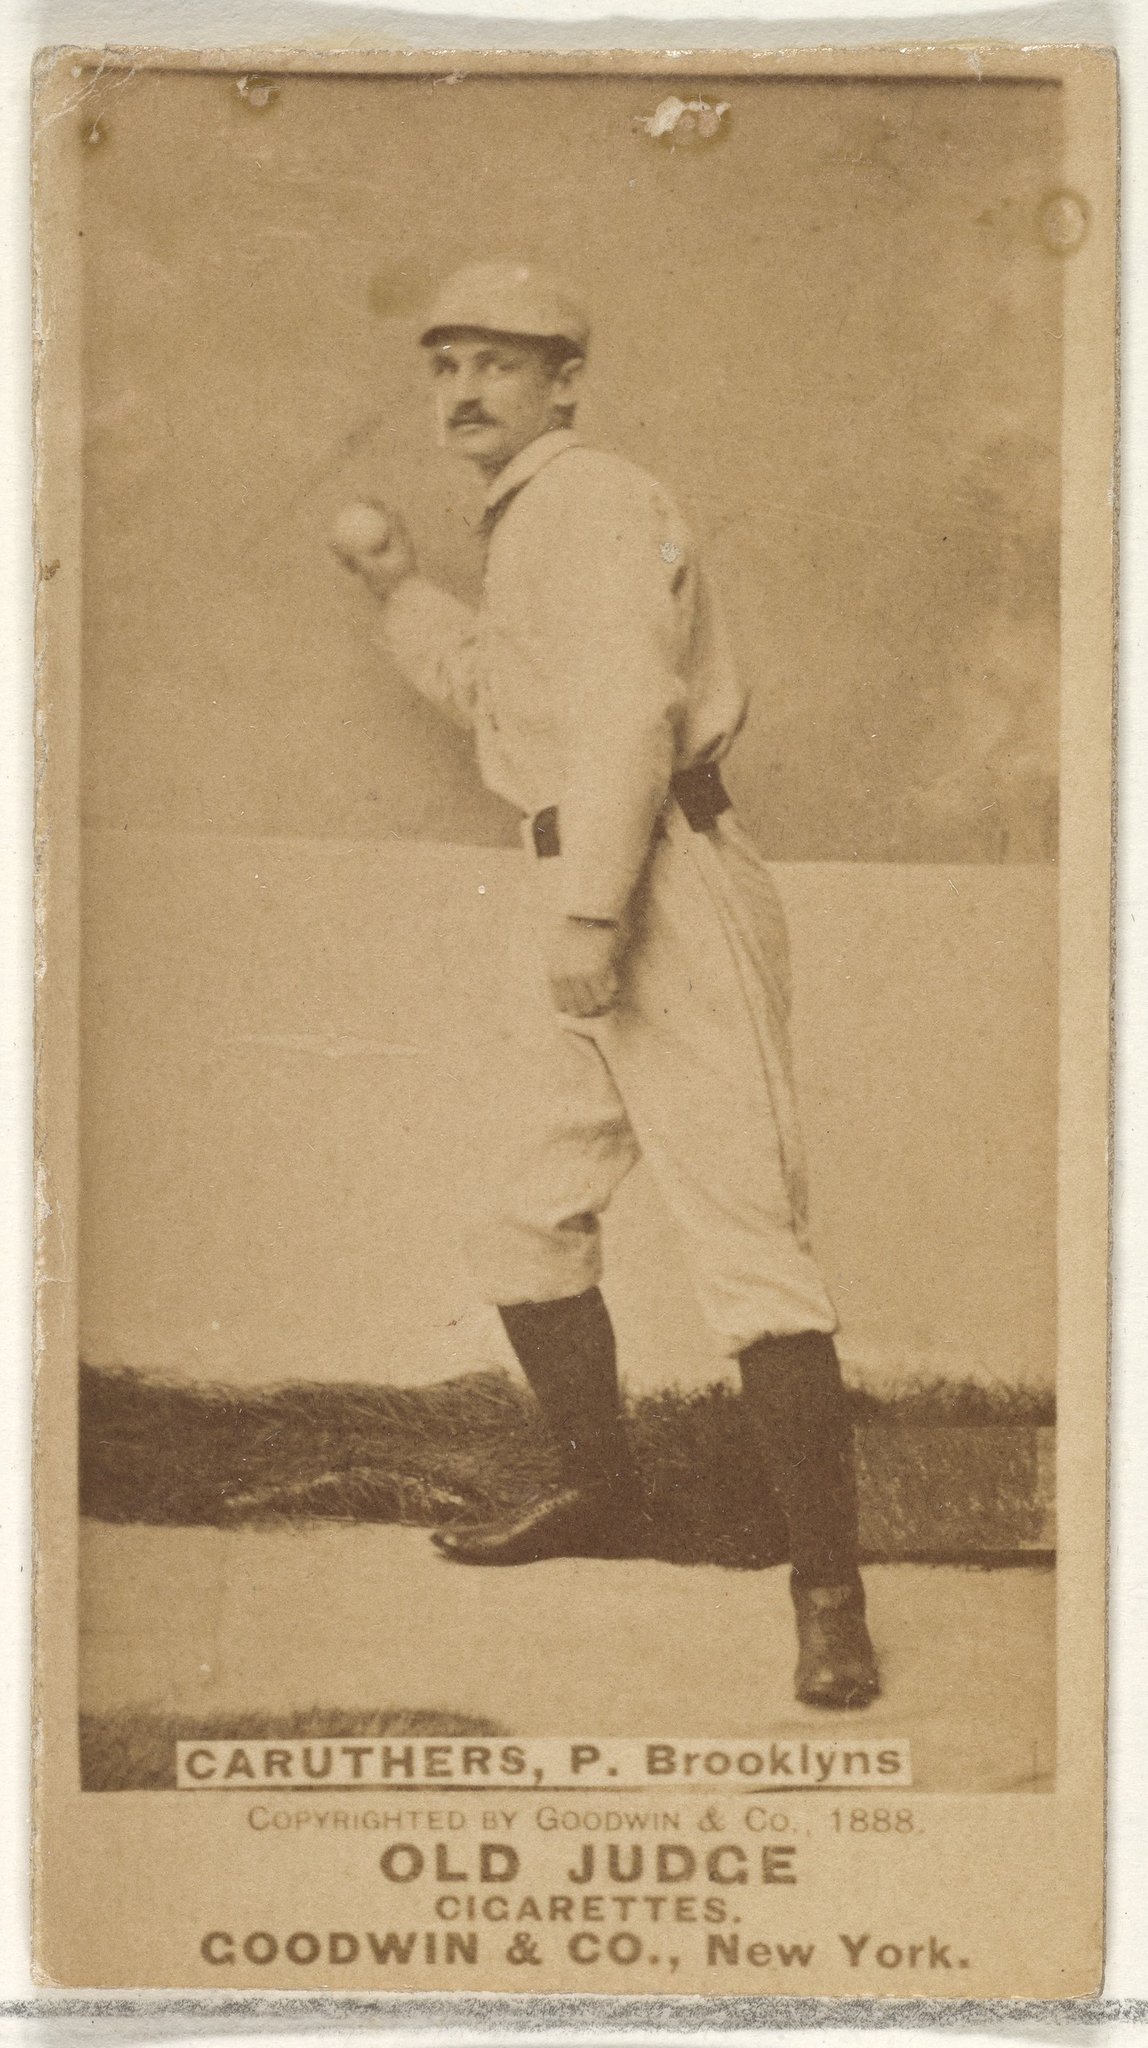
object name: baseball card, photograph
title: Caruthers, Pitcher, Brooklyn, from the Old Judge series (N172) for Old Judge Cigarettes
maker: goodwin & company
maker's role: publisher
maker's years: 1850-1950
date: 1888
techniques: albumen silver print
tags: men,portraits,baseball,athletes